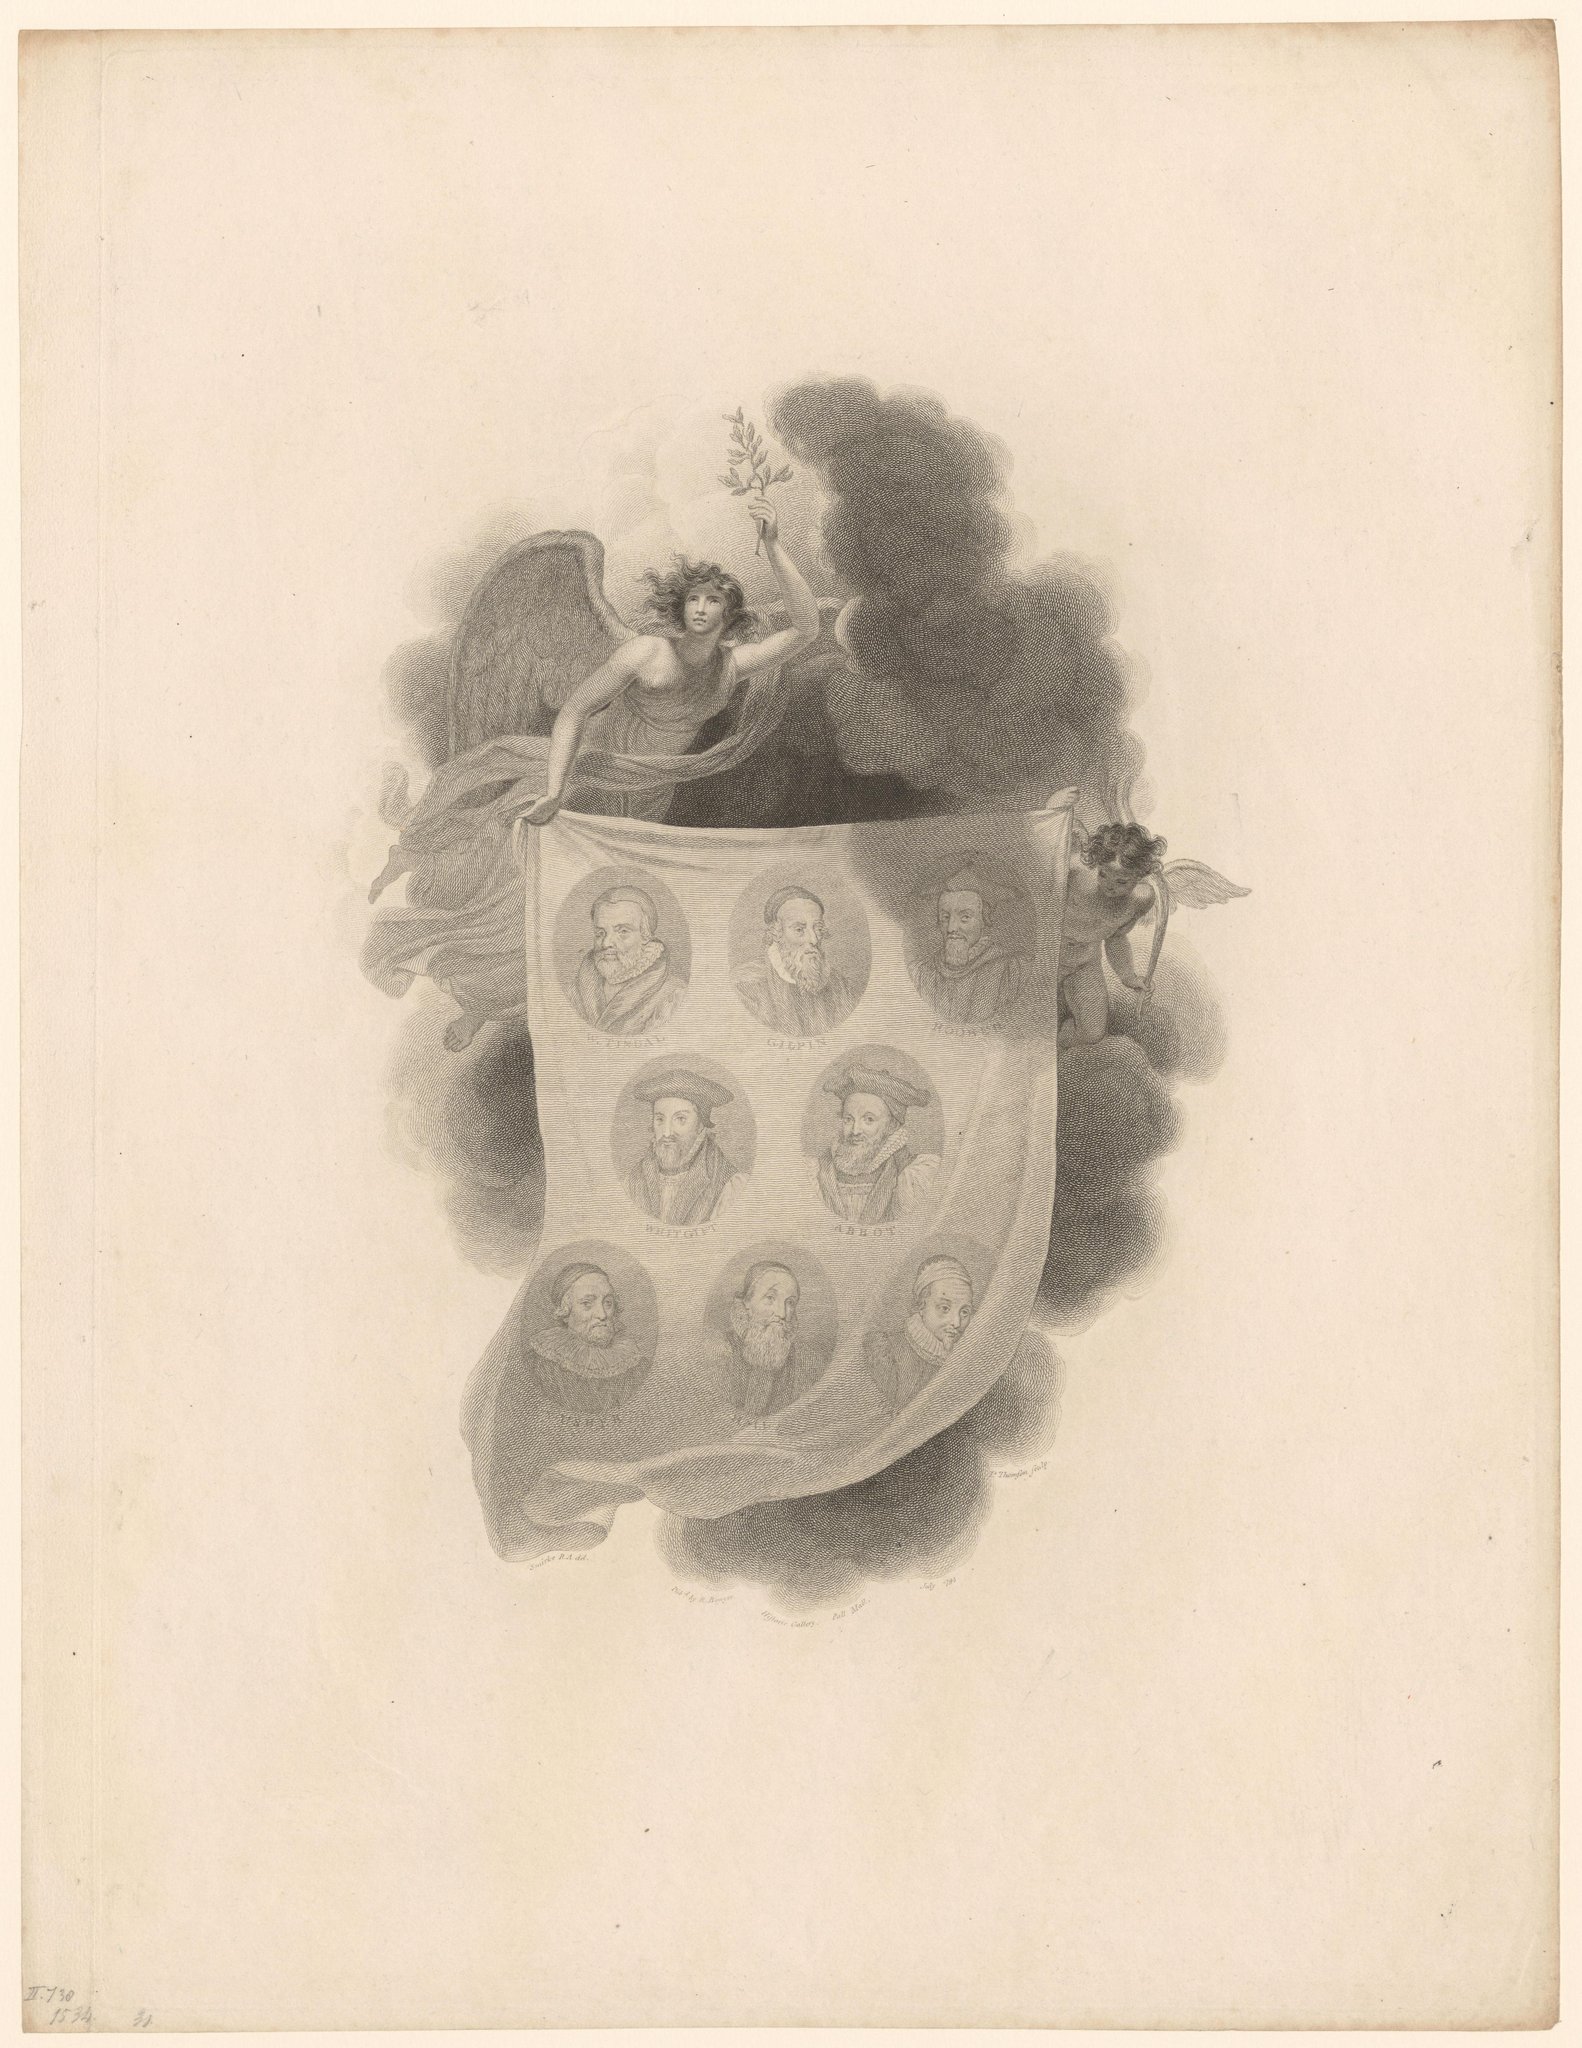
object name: print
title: W. Tindal, Gilpin, Hooker, Whitgift, Abbot, Usher, Hall [?]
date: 1707-1795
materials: paper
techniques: etching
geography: london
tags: priest, archbishop, bishop, etc. (roman catholic), historical persons, cupids: 'amores', 'amoretti', 'putti', angels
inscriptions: collector's mark: Lugt 2228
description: De prenten uit deze serie zijn naar schilderijen en tekeningen uit Bowyer's Historic Gallery. Deze schilderijen en tekeningen illustreerden de gebeurtenissen uit David Hume's History of England. De prenten zijn daarom mogelijk gebruikt als illustratie in deze boeken.